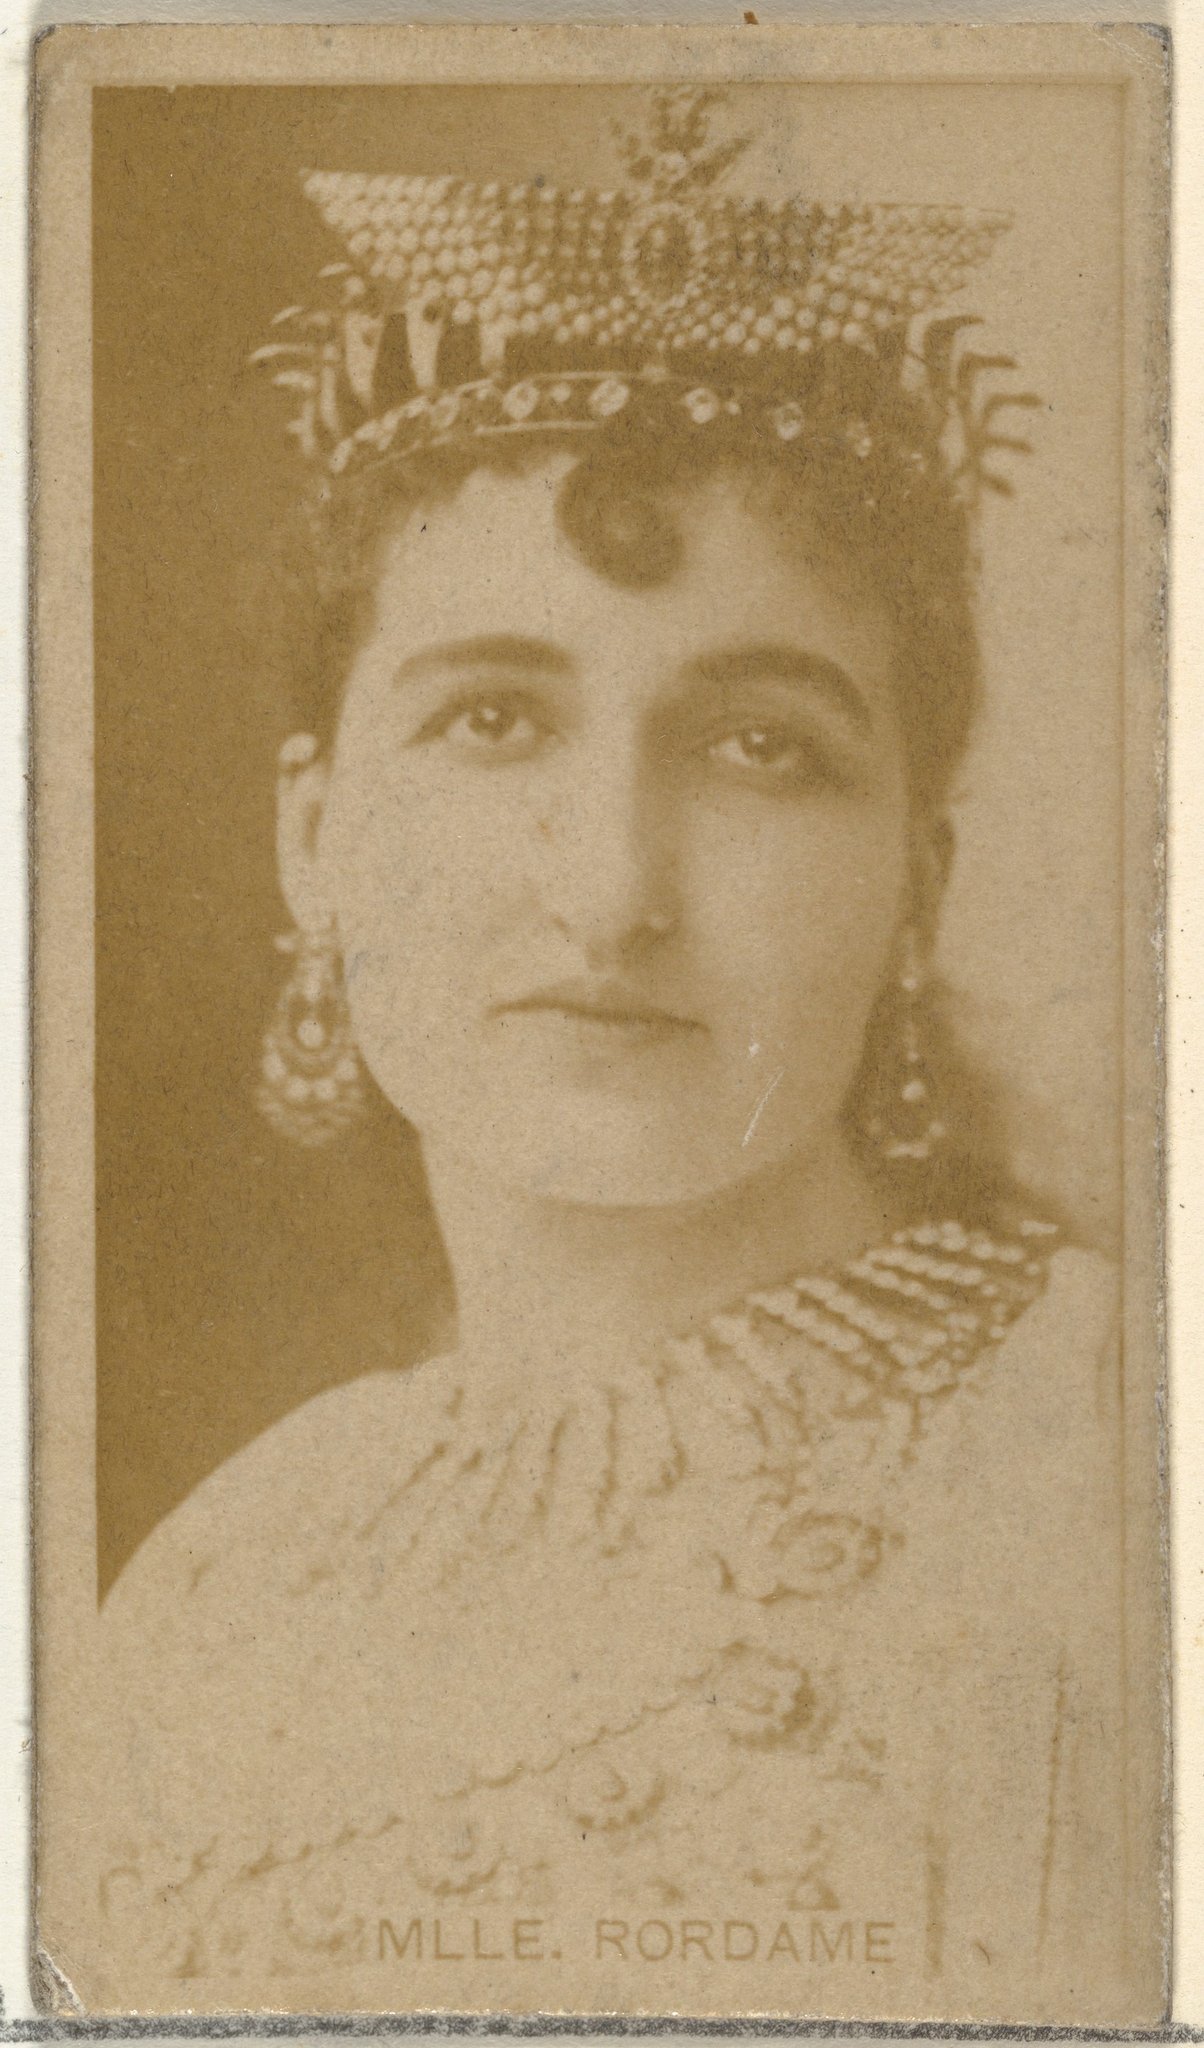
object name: photograph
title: Mlle. Rordame, from the Actors and Actresses series (N145-8) issued by Duke Sons & Co. to promote Duke Cigarettes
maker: w. duke, sons & co.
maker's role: publisher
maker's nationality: american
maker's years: 1870-1920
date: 1891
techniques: albumen silver print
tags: portraits,women,actresses